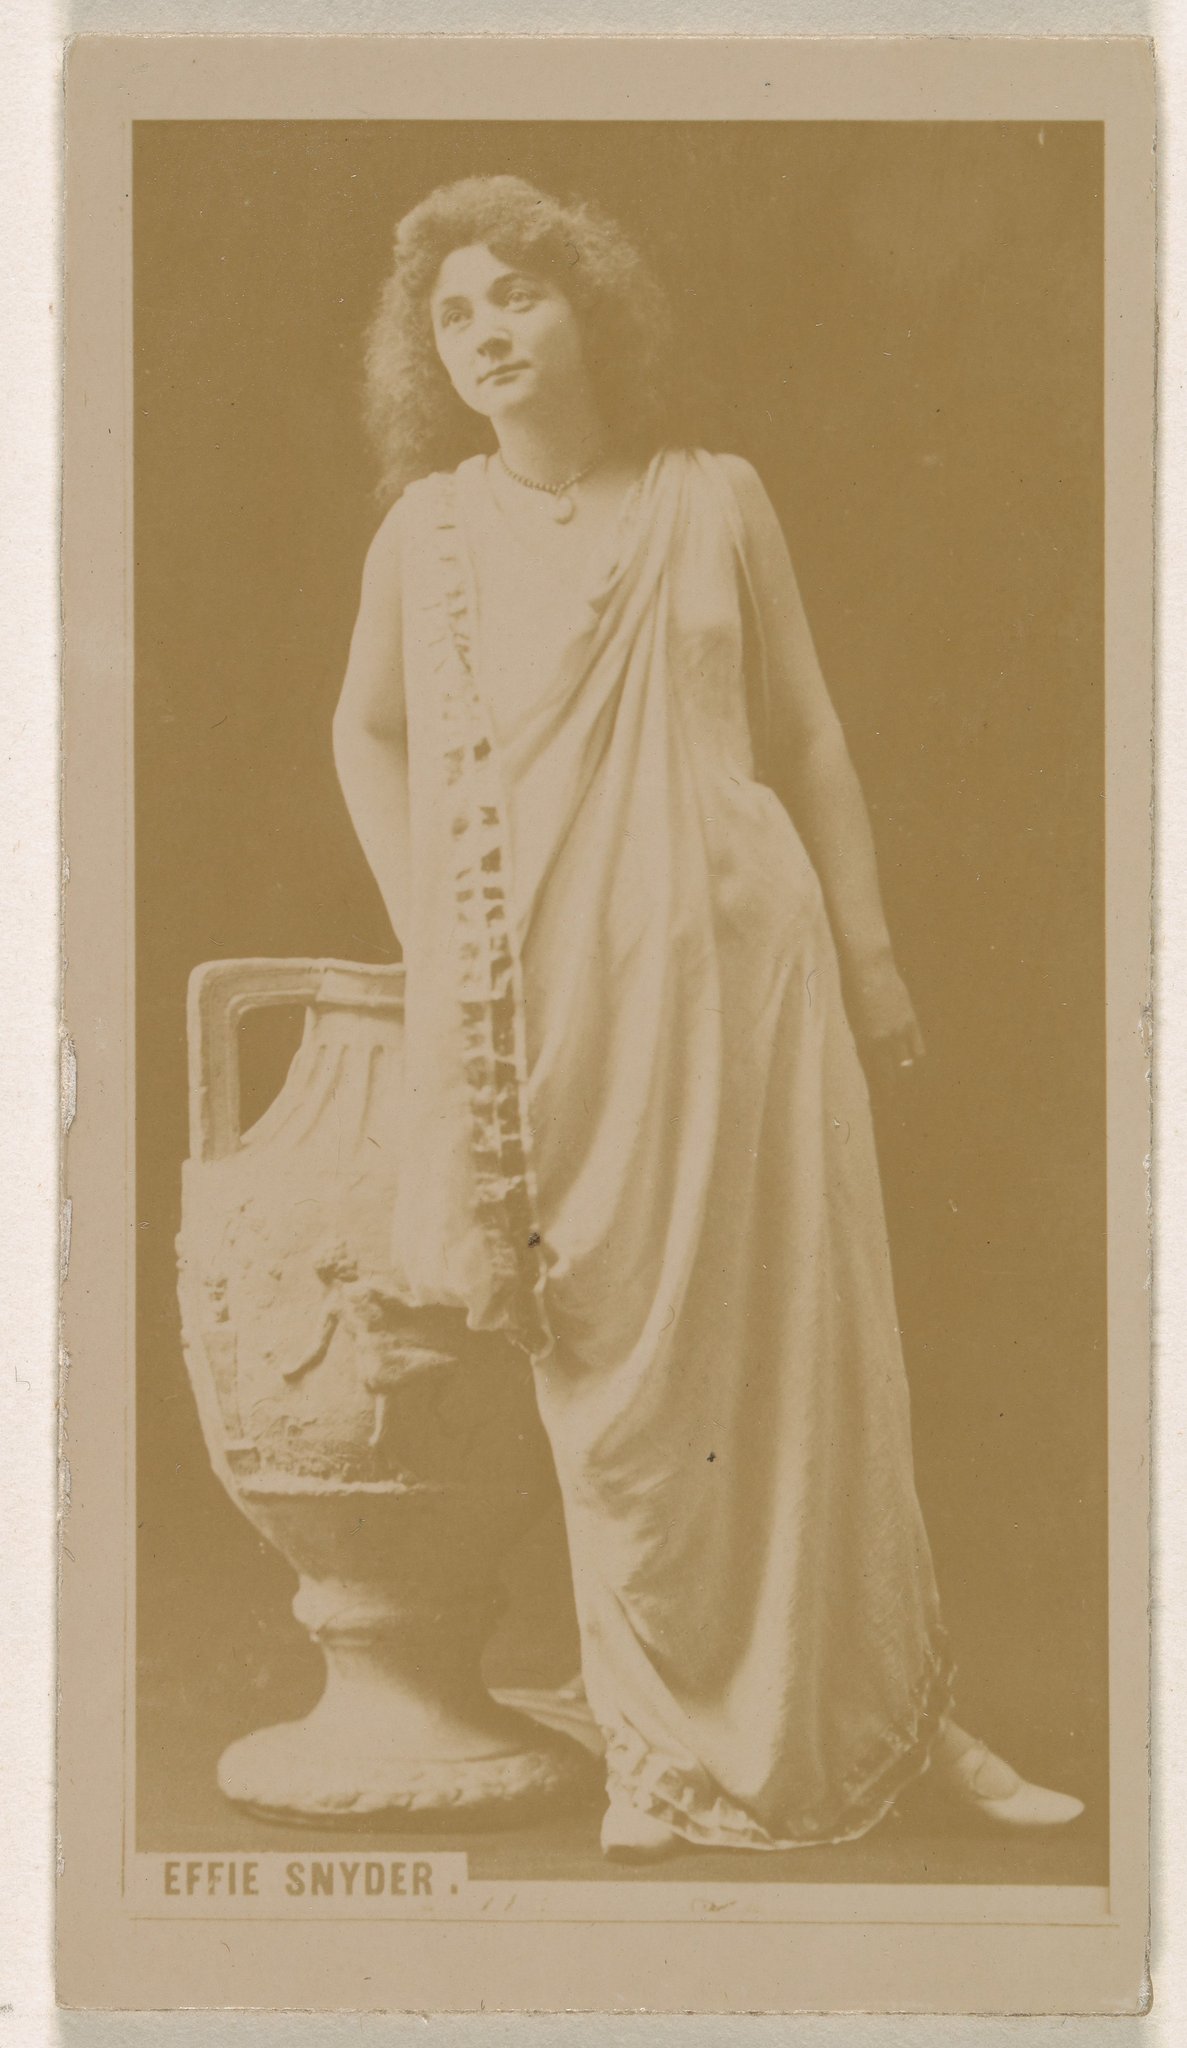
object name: photograph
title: Effie Snyder, from the Actresses series (N245) issued by Kinney Brothers to promote Sweet Caporal Cigarettes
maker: kinney brothers tobacco company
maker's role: publisher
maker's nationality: american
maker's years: 1869-2011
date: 1890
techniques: albumen silver print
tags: portraits,women,actresses